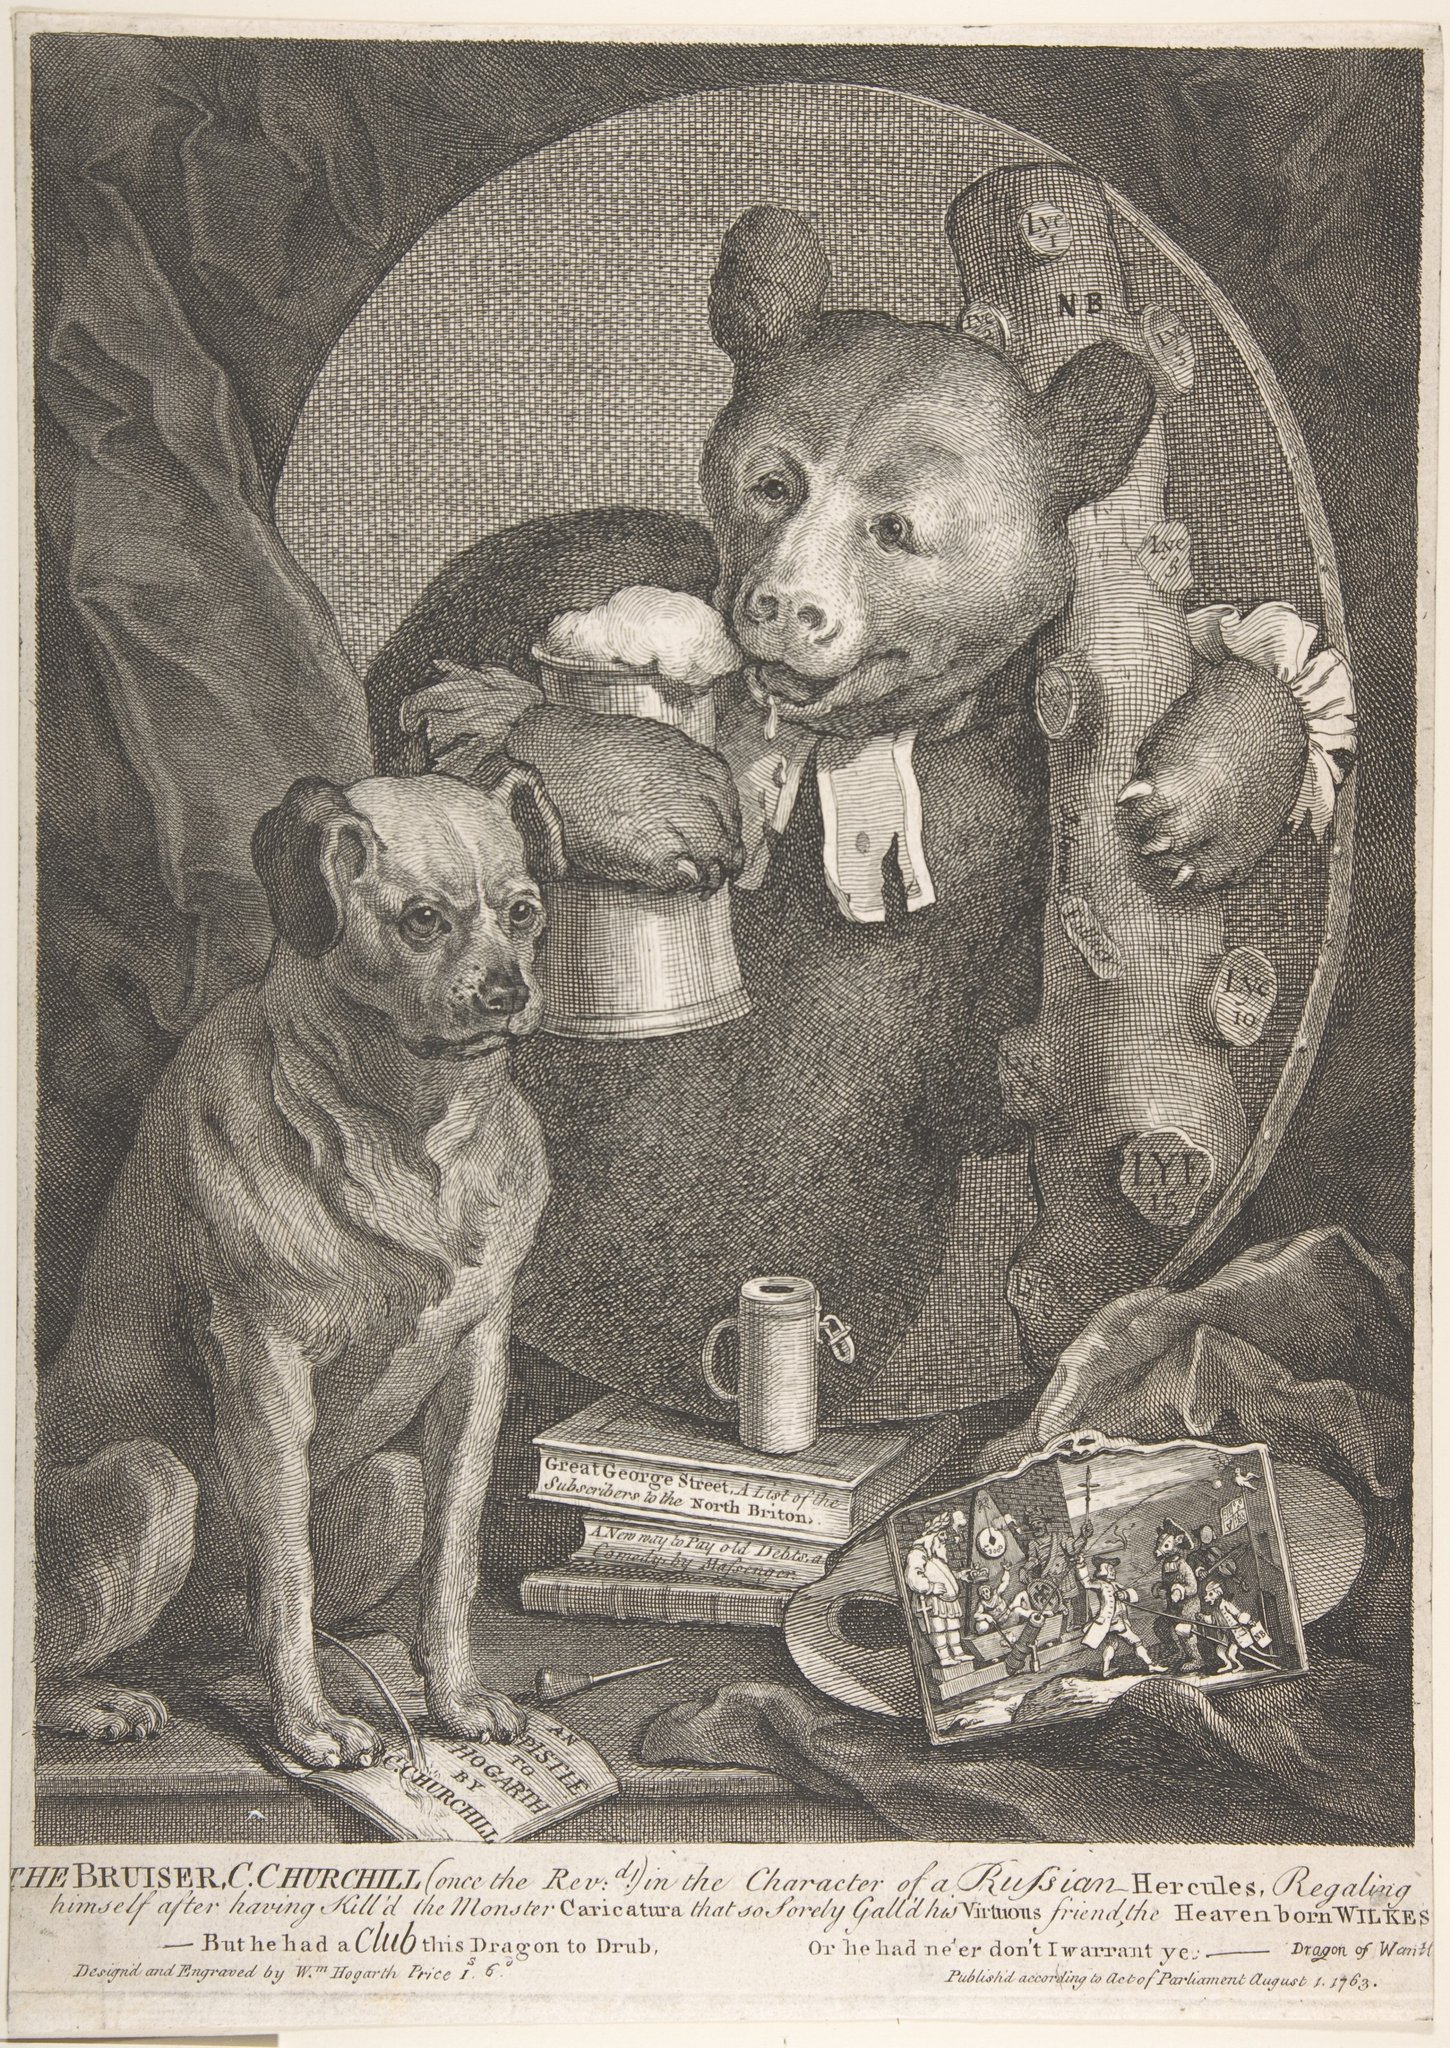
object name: print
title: The Bruiser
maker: william hogarth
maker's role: artist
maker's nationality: british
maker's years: 1697-1764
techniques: engraving, etching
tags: bears,satire,dogs,drinking